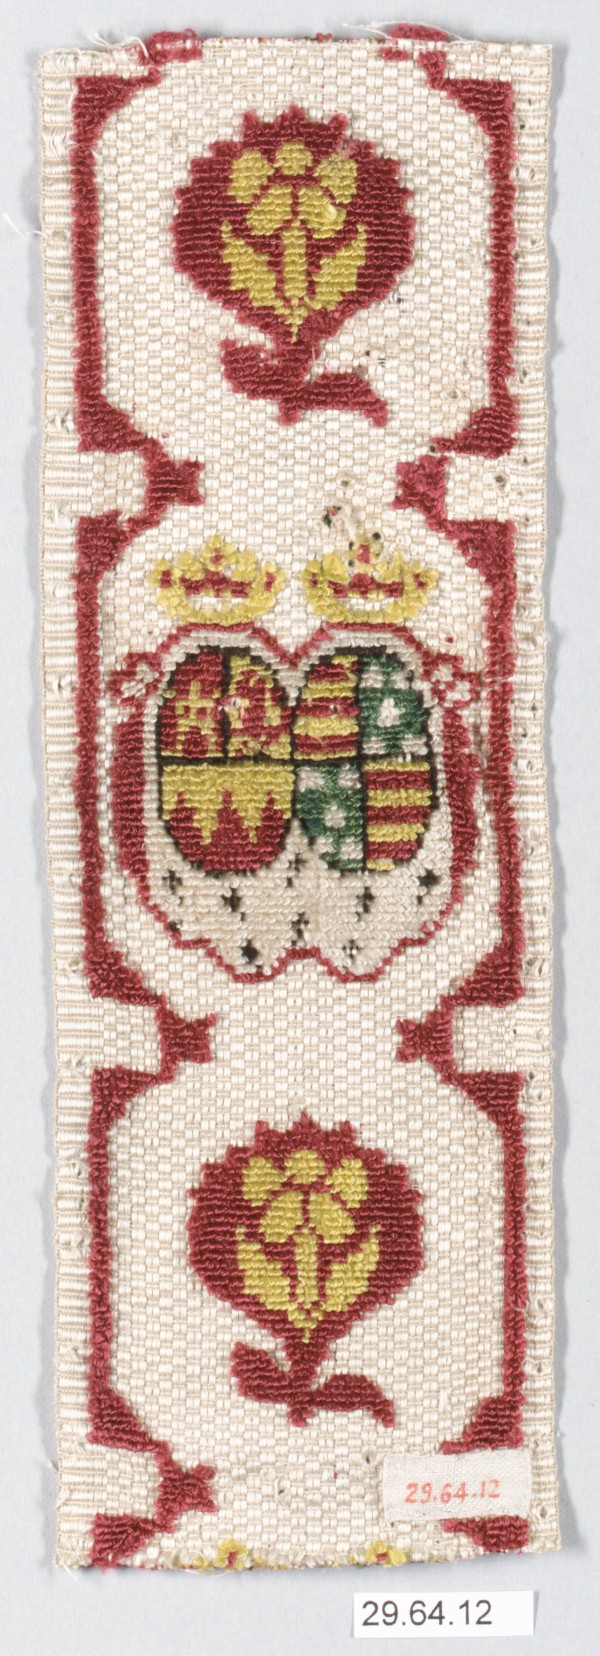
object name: galloon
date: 1701-1900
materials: silk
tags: flowers